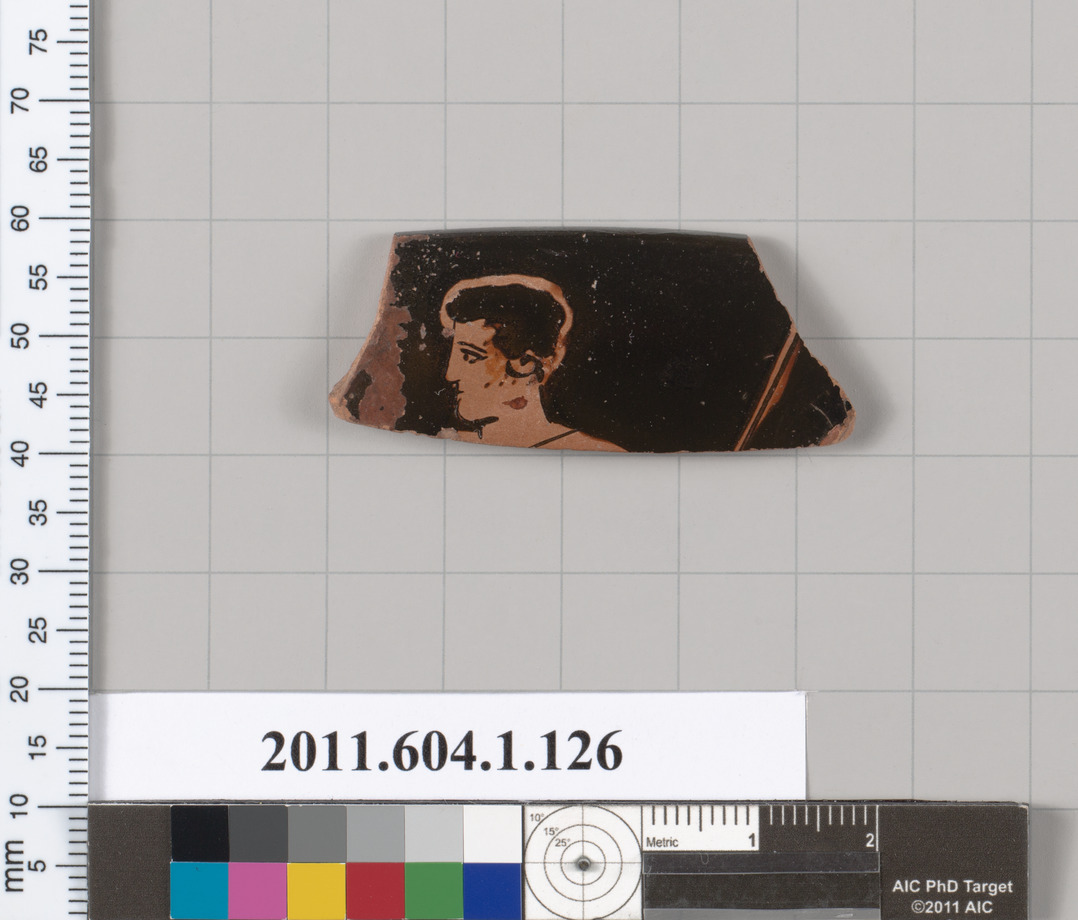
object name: kylix fragment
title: Terracotta rim fragment of a kylix (drinking cup)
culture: greek, attic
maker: koropi painter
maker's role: artist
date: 475-451 BCE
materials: terracotta